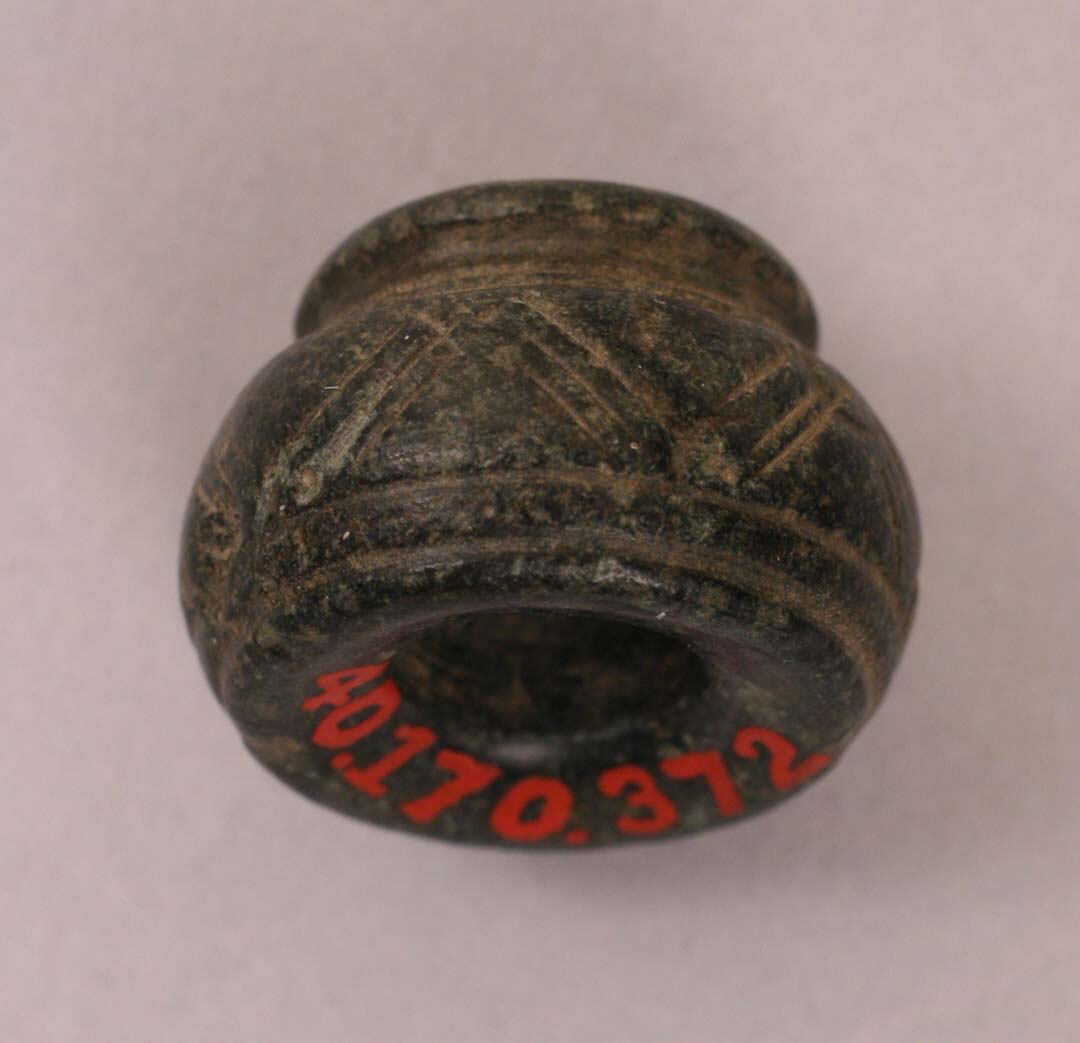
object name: button or bead or spindle whorl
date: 801-1000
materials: stone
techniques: incising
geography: iran